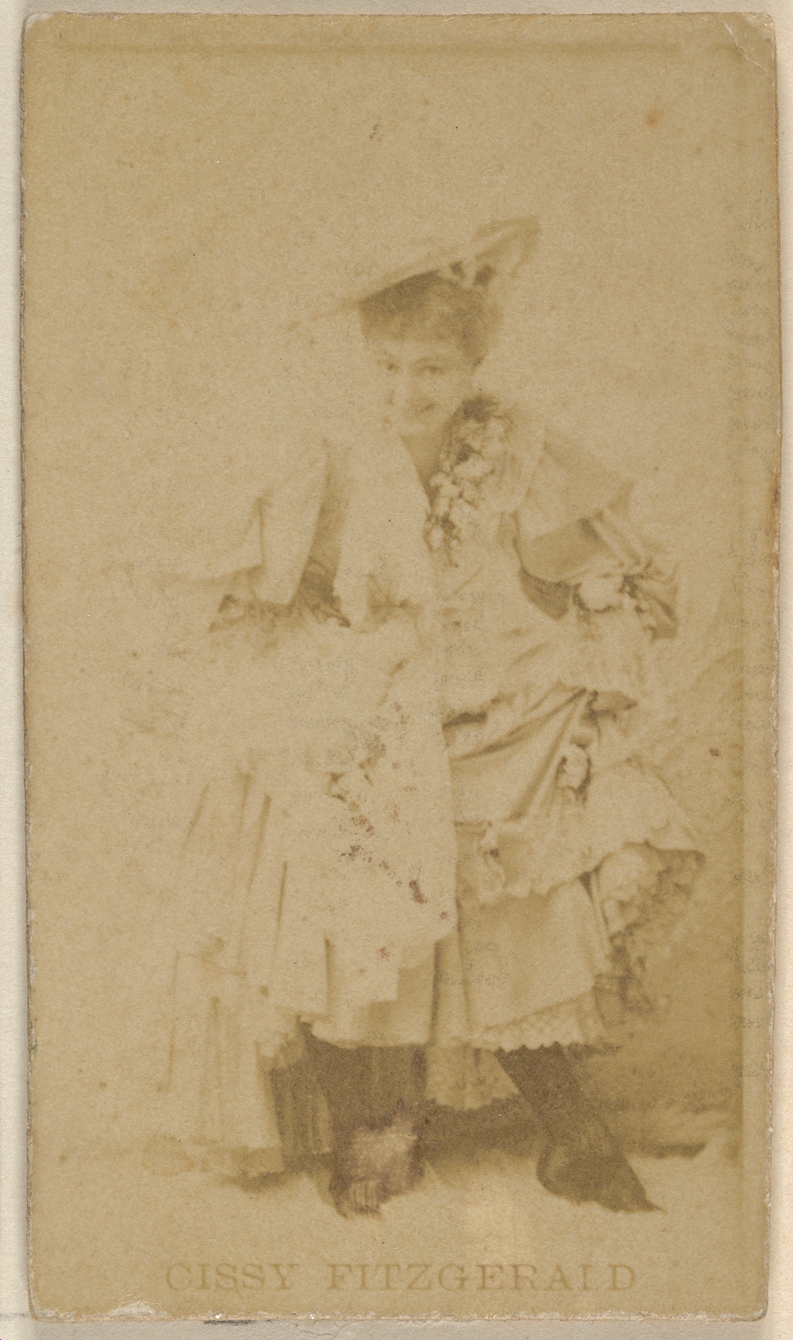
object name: photograph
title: Cissy Fitzgerald, from the Actors and Actresses series (N45, Type 8) for Virginia Brights Cigarettes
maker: allen & ginter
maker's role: publisher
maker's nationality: american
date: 1888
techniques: albumen silver print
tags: portraits,women,actresses